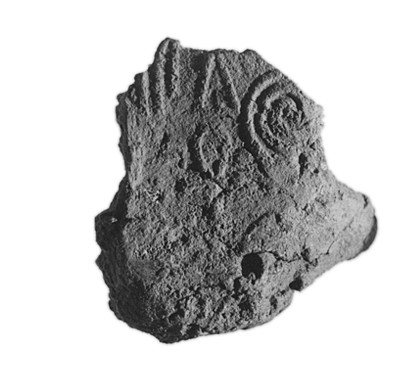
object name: sealing, administrative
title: Administrative Seal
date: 1981-1640 BCE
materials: clay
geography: egypt